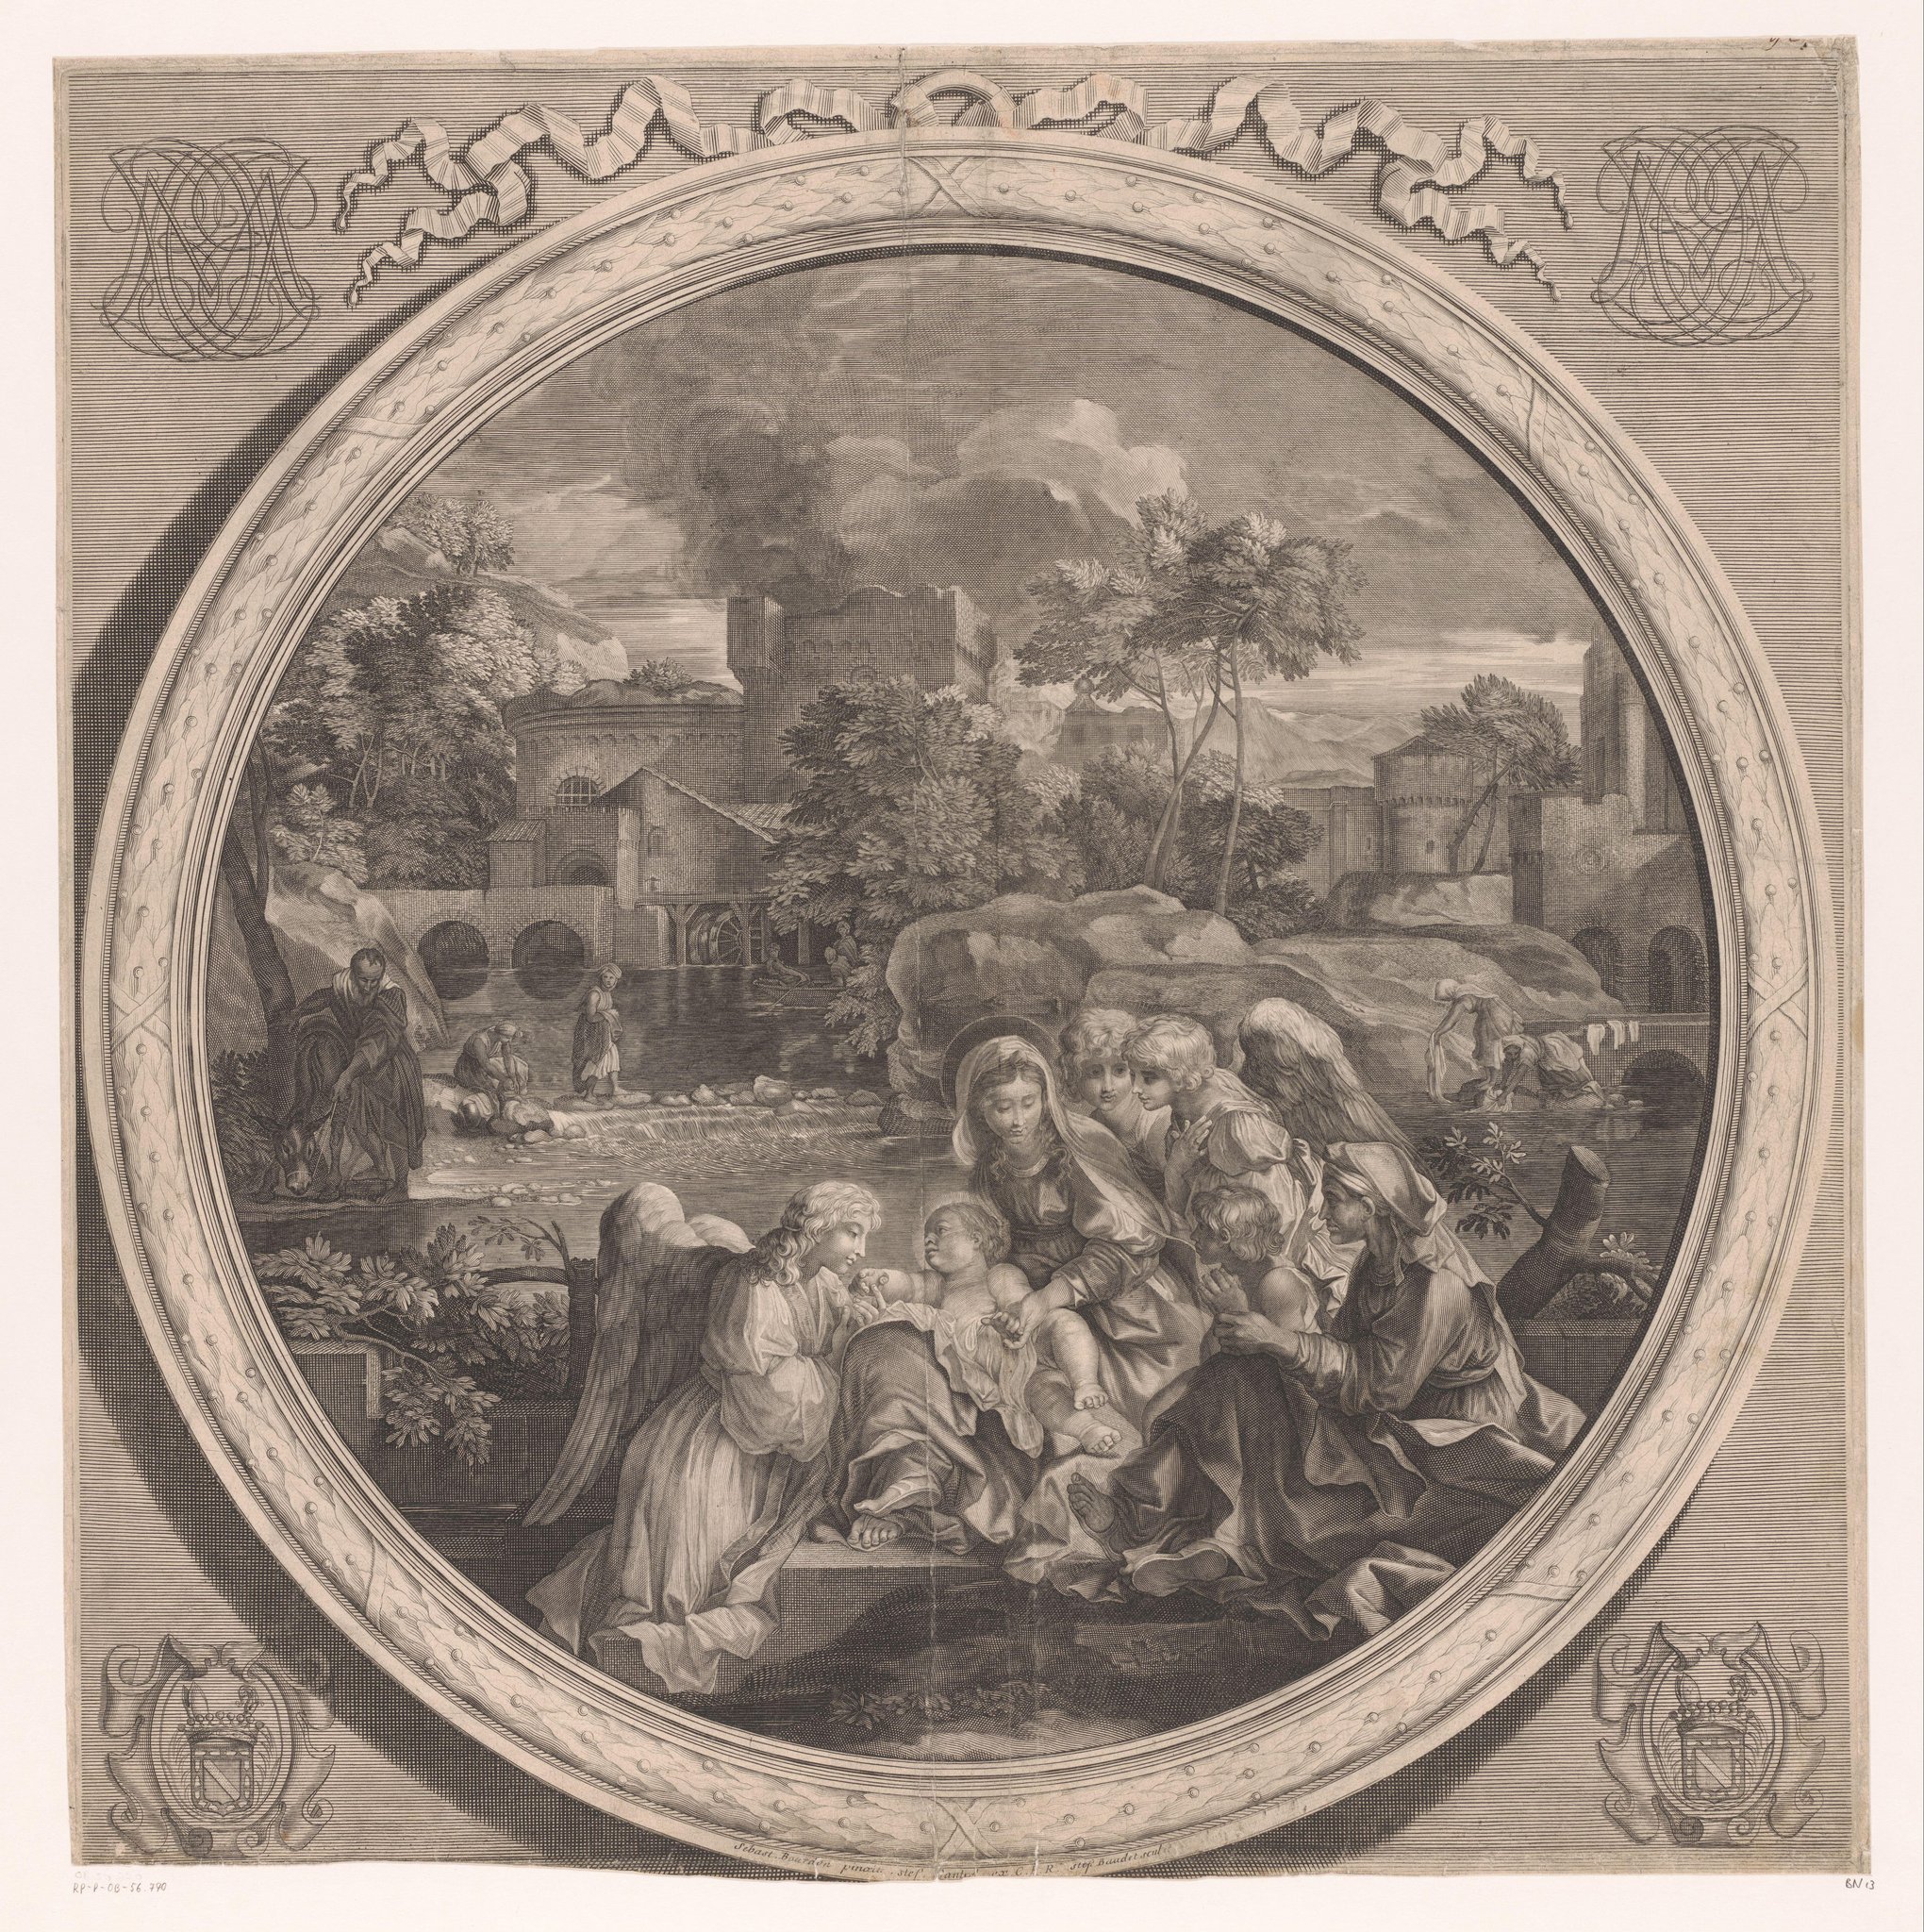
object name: print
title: Rust op de vlucht naar Egypte met engelen, Johannes en Elisabeth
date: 1648-1711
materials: paper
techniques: engraving, etching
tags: holy family, and derived representations, rest on the flight into egypt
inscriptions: collector's mark: Lugt 240